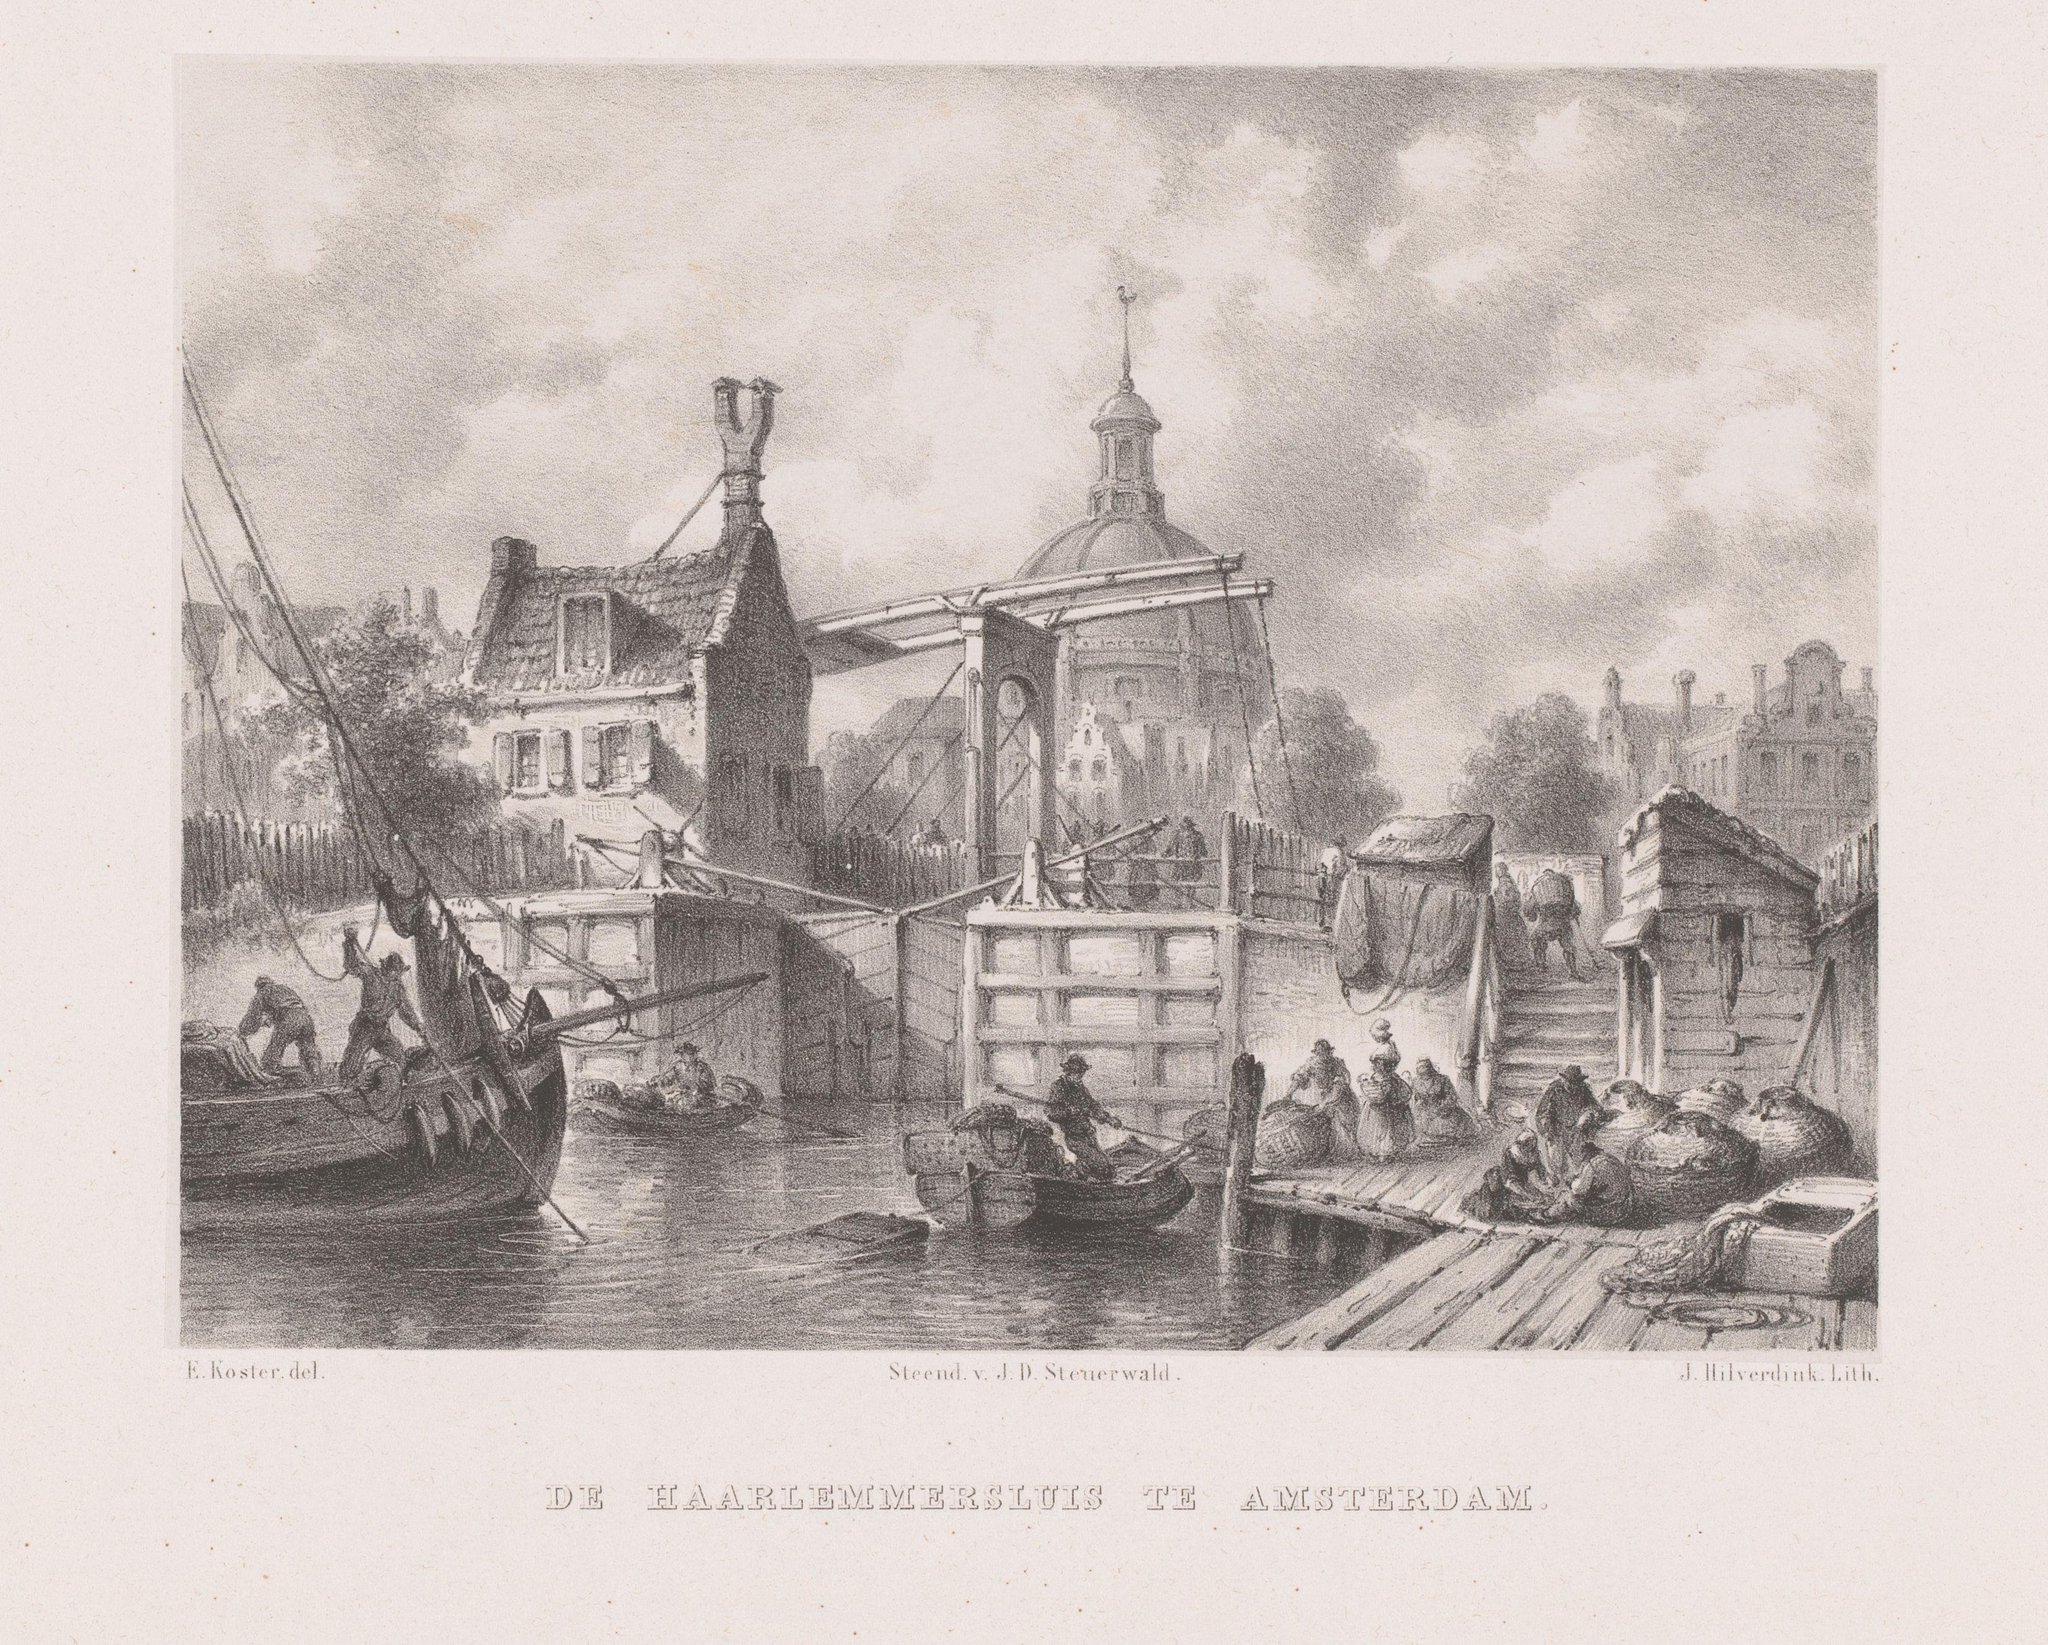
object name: print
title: De Haarlemmersluis te Amsterdam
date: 1858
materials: paper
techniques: lithograph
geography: amsterdam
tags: sluice, weir, ships (in general), amsterdam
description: Deze prent komt uit: Koster, E. 'E. Koster's schetsboek: Nederlandsche Stads- en Havengezichten, uitgegeven onder medewerking van de maatschappij Arti et Amicitiae, Amsterdam, F. Buffa en Zn., e.a.' Amsterdam 1858.